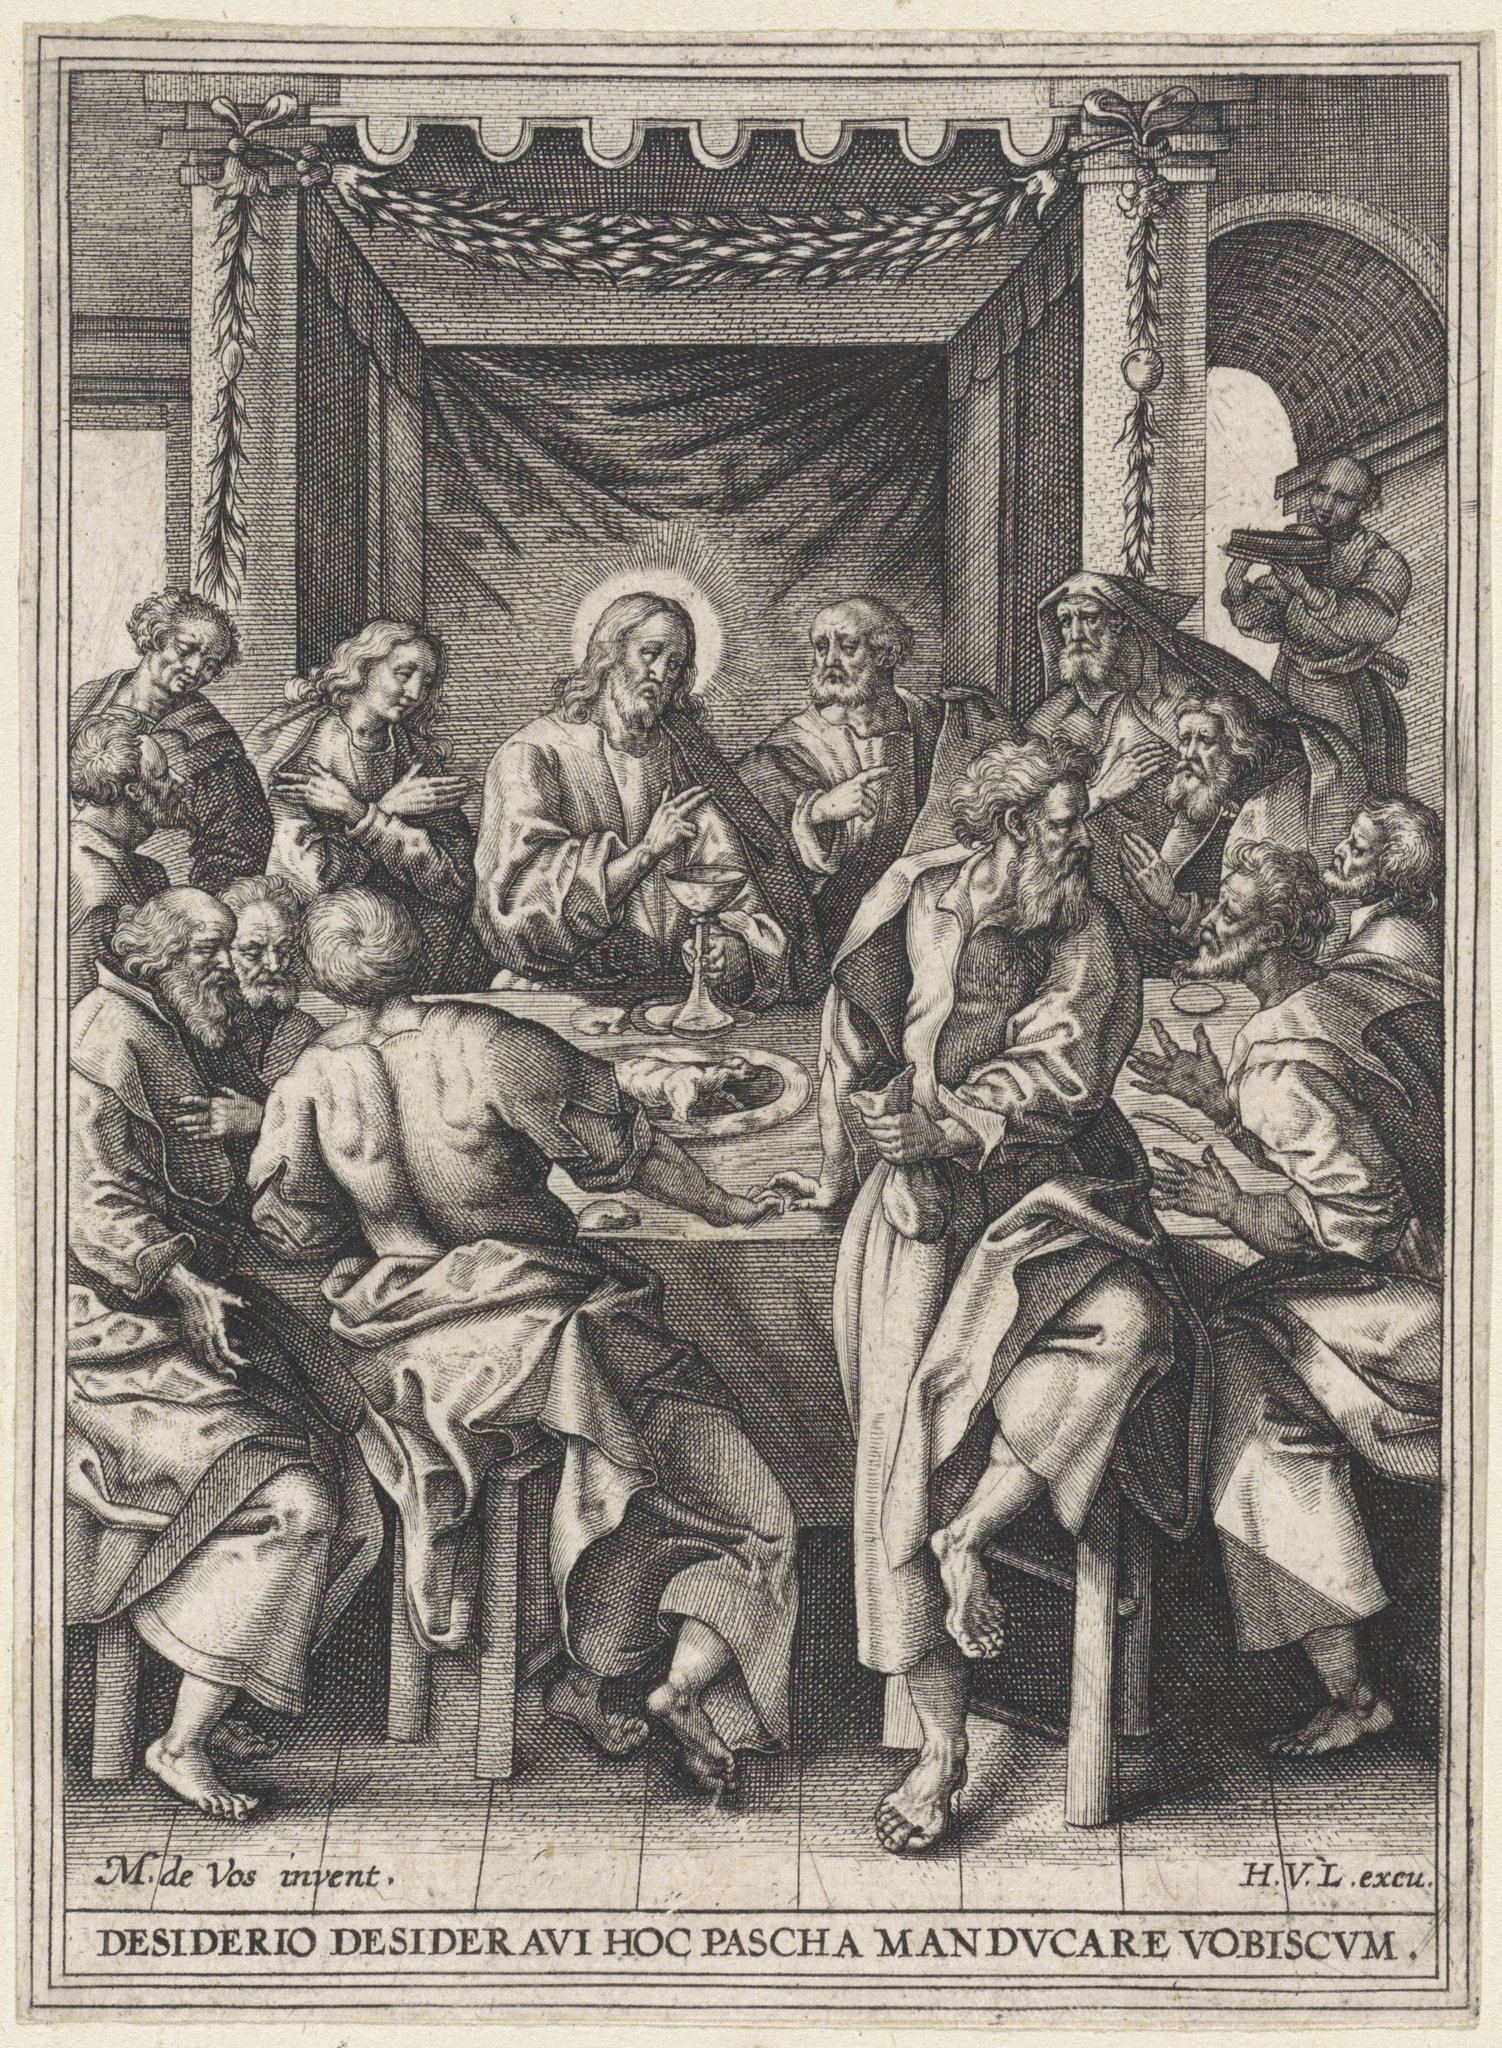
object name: print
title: Scènes uit het lijdensverhaal van Christus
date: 1560-1600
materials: paper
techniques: engraving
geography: low countries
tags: last supper (in general) (matthew 26:21-35; mark 14:18-31; luke 22:3, 22:15-23; john 13:21-38)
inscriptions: collector's mark: Lugt 240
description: Laatste Avondmaal. Onder een éénregelige toelichting in het Latijn.